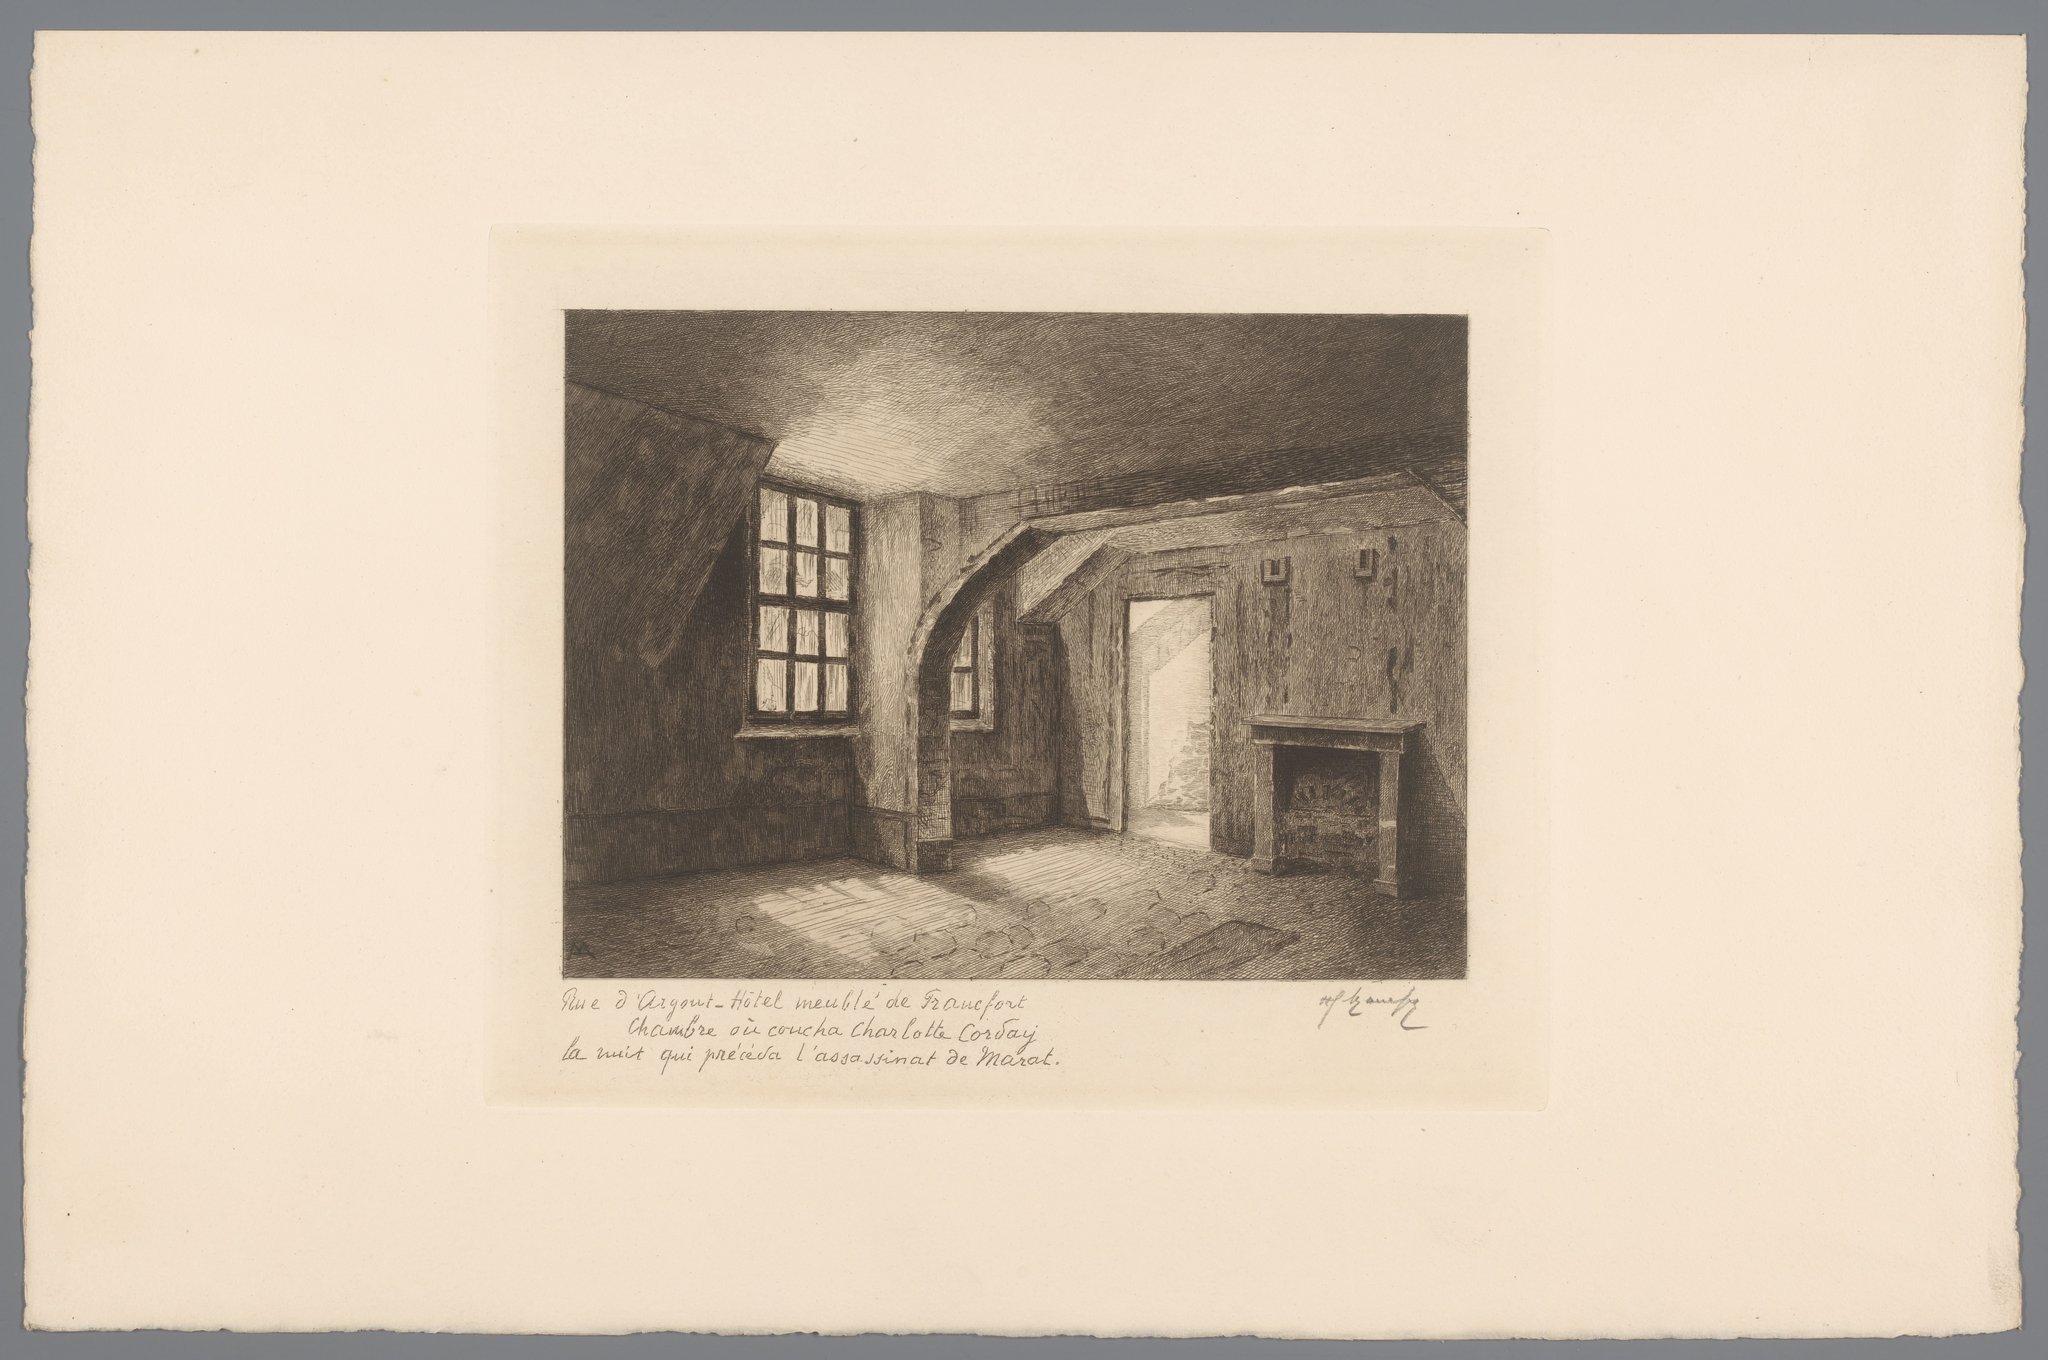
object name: print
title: Kamer waarin Charlotte Corday sliep de nacht voor de moord op Jean-Paul Marat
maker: henri manesse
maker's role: print maker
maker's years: 1854-1940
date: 1906-1911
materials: paper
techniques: drypoint, engraving, etching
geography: france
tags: hotel room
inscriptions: collector's mark: Lugt 2228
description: Dit is de eerste serie uit een prentreeks die uit minstens elf series bestaat.